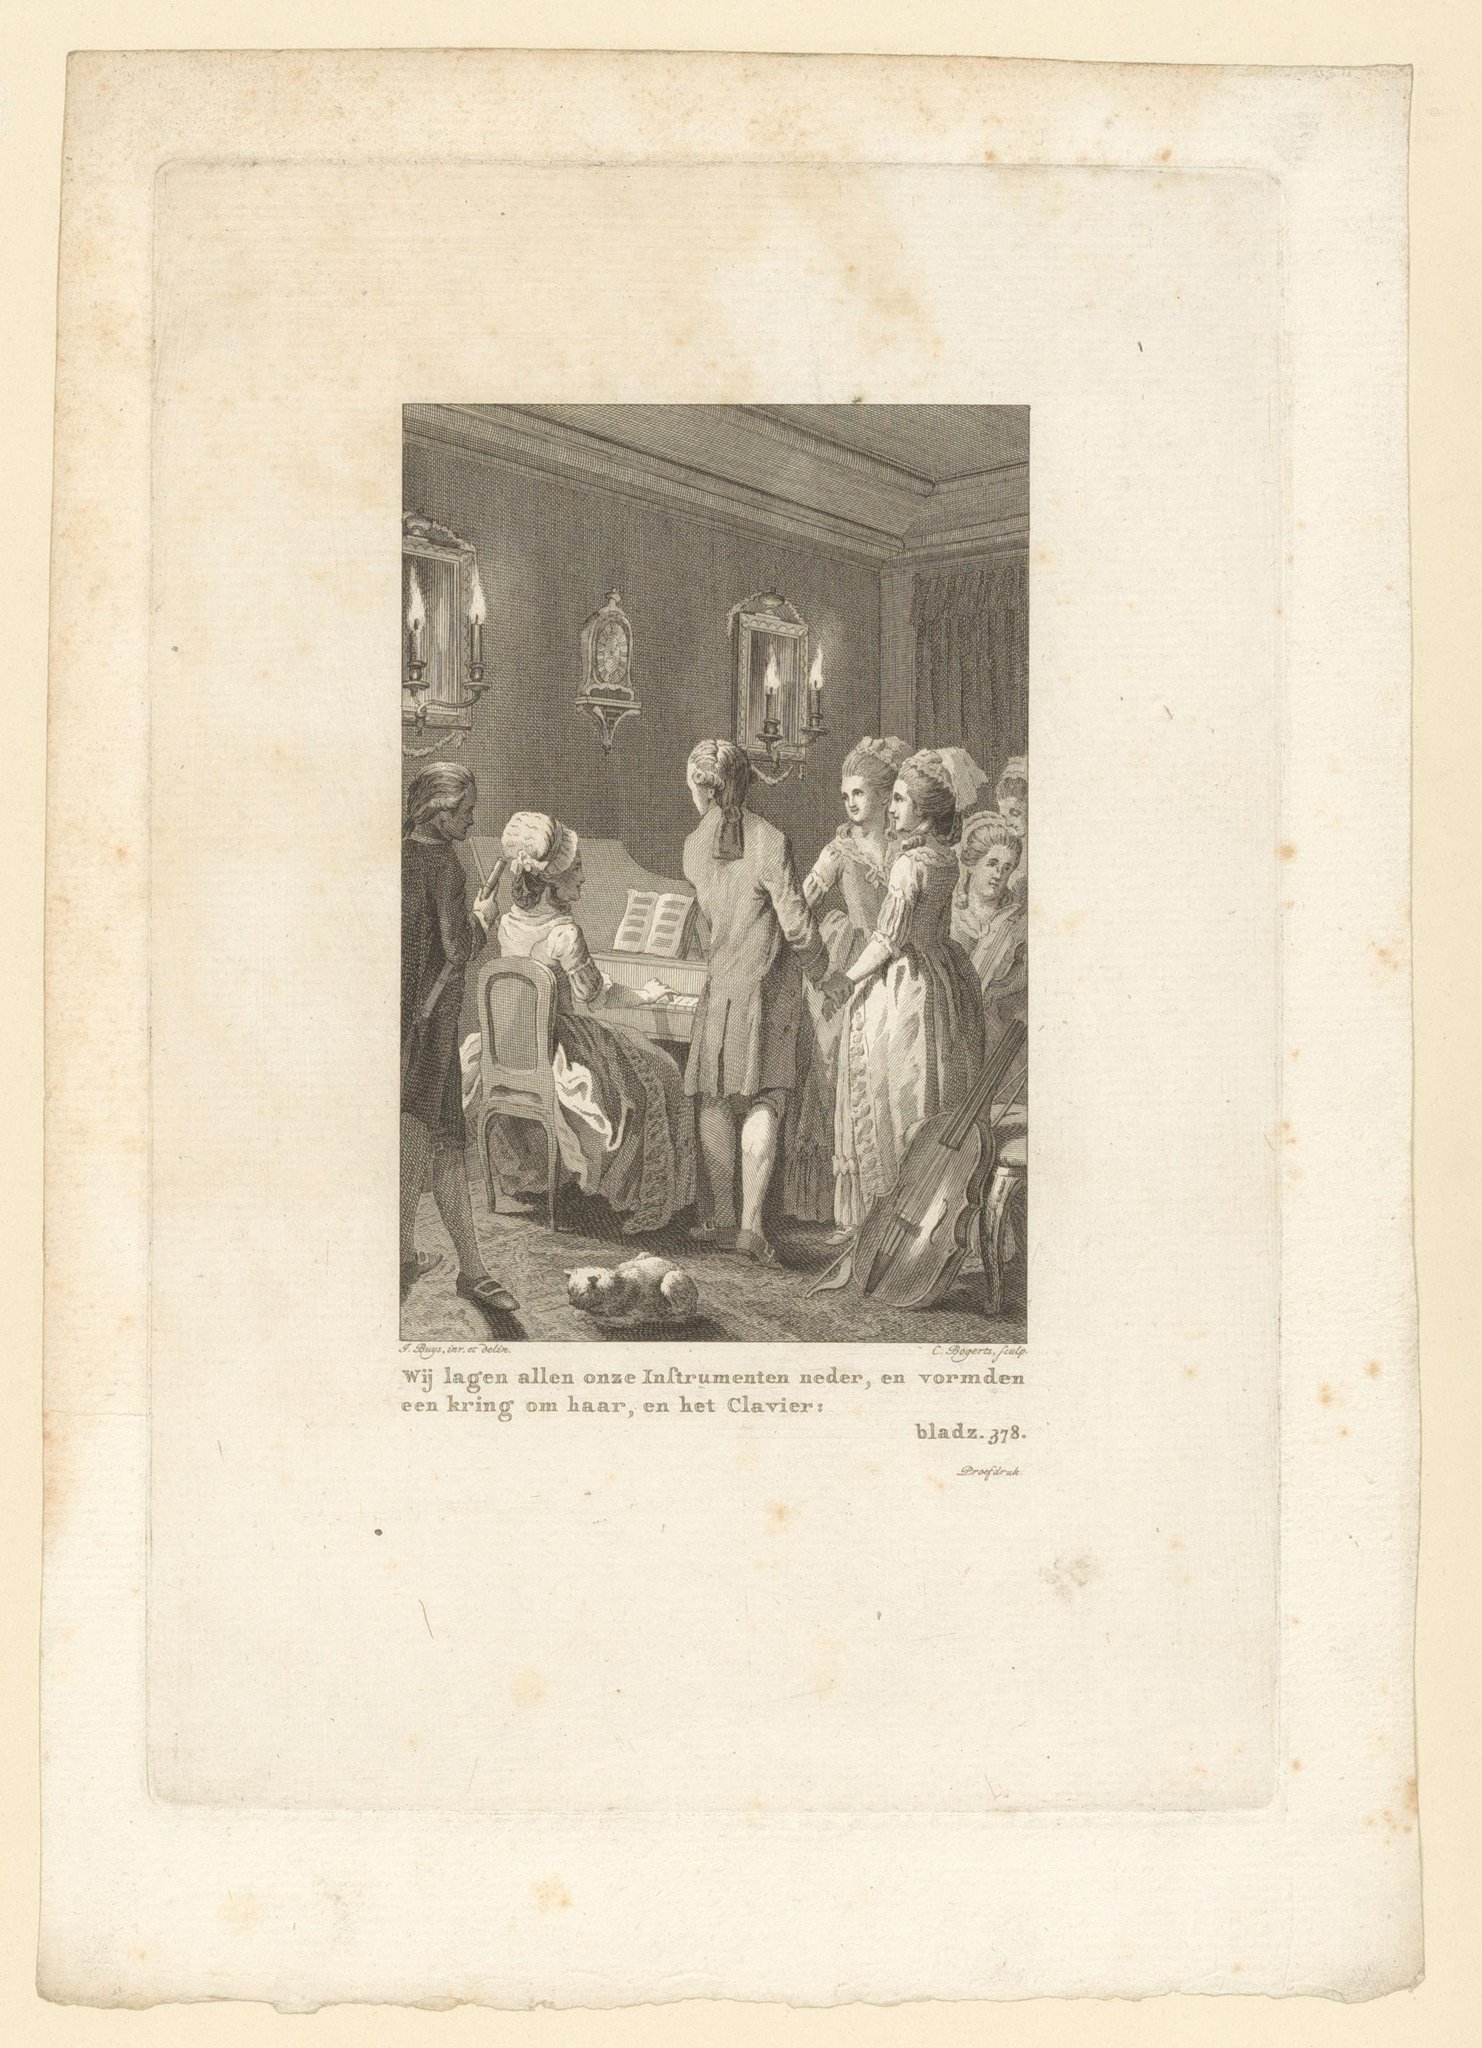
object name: book illustration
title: Wij lagen allen onze Instrumenten neder (...)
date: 1782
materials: paper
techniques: engraving, etching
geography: netherlands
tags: one person playing keyboard instrument, small group of musicians, chamber orchestra, jazz band, visiting; receiving guests; elegant company, communal rooms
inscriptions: collector's mark: Lugt 1641, collector's mark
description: Gebruikt als illustratie in: E. Bekker en A. Deken, Historie van mejuffrouw Sara Burgerhart, Den Haag: Isaac van Cleef, 1782.